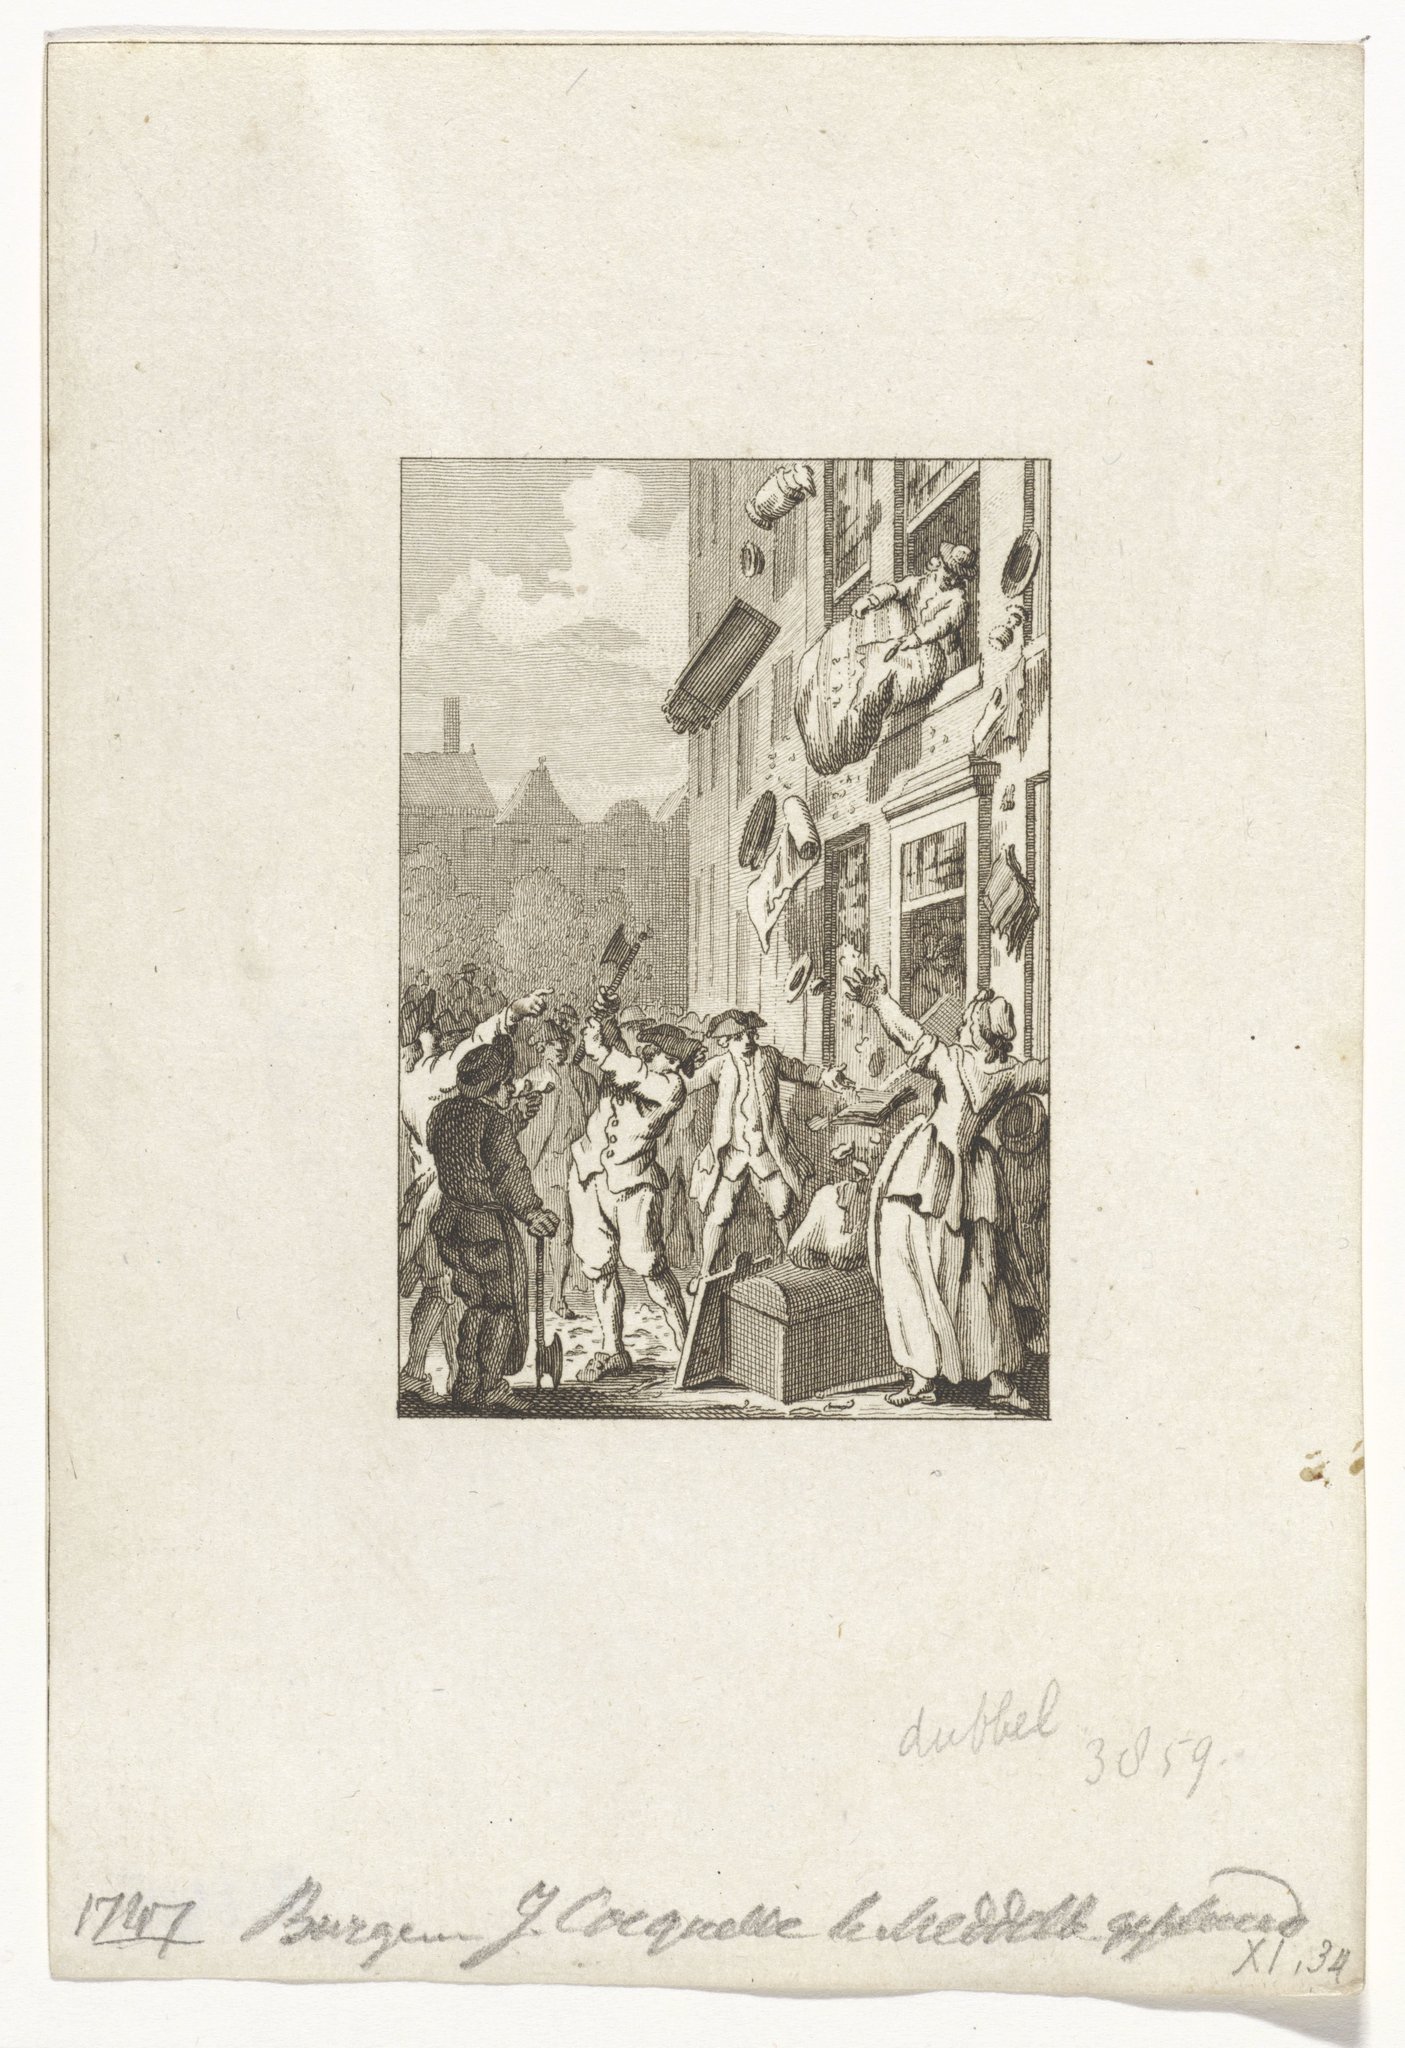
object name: history print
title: Plundering van het huis van burgemeester Johannes Cocquelle te Middelburg, 1747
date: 1783-1795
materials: paper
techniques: etching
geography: amsterdam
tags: mayor, plundering ~ riot, middelburg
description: De plundering van het huis van burgemeester Johannes Cocquelle te Middelburg op 24 april 1747 door een prinsgezinde meute die vermoeden dat de burgemeester uit de stad zou willen vluchten door de aanstelling van Willem IV als stadhouder bij de Franse dreiging.